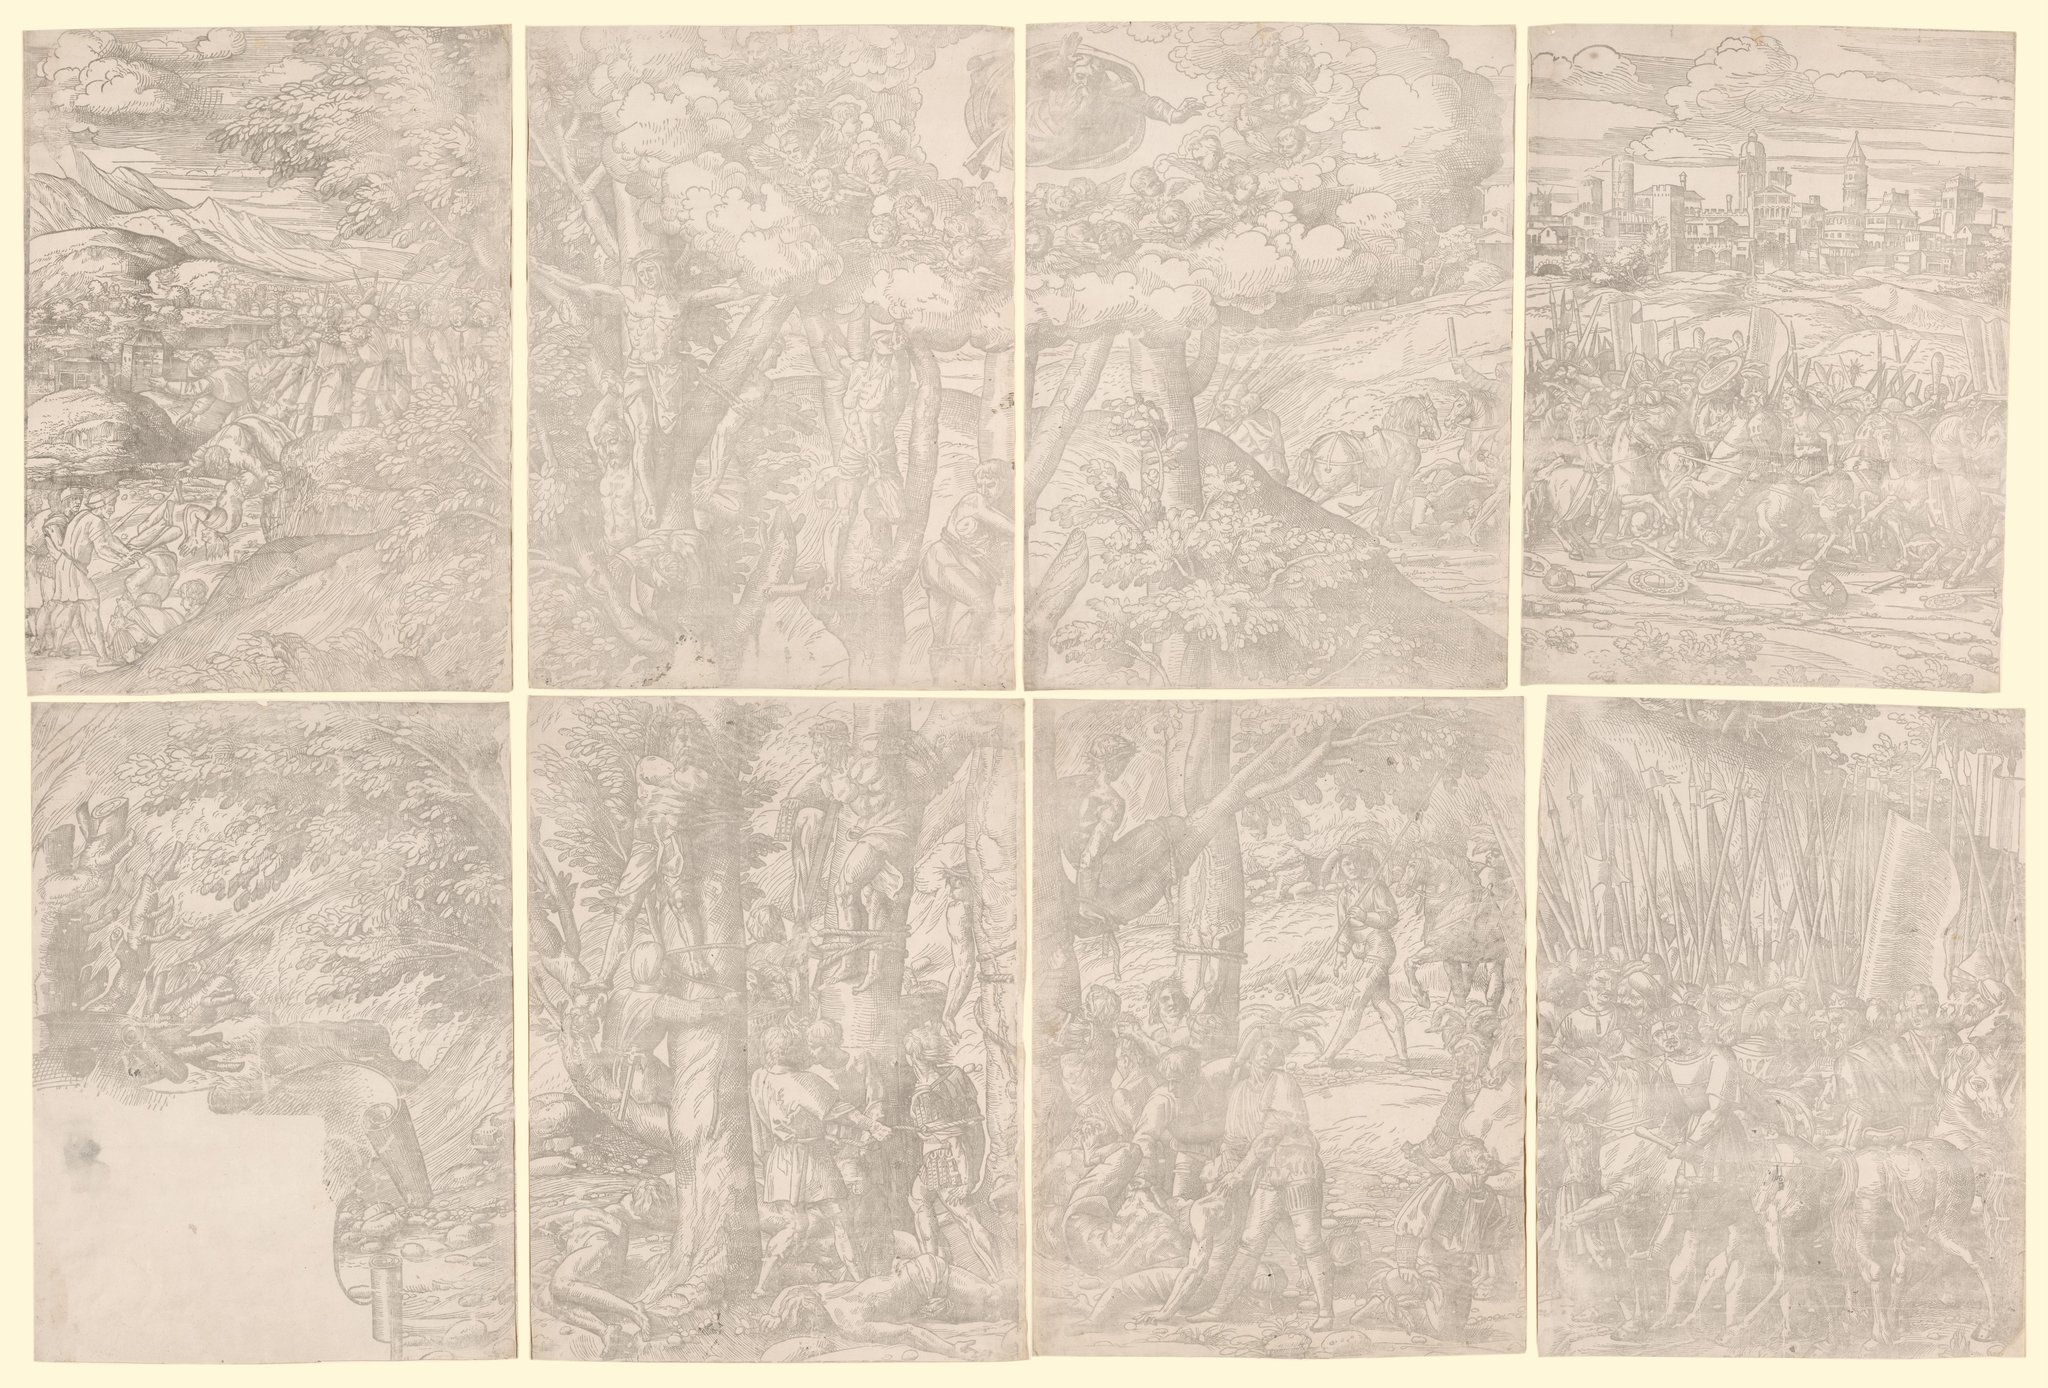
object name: print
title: Martelaarschap van de tienduizend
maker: domenico campagnola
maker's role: draughtsman, painter, print maker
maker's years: 1500-1564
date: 1515-1520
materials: paper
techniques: printmaking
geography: italy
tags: city-view in general; 'veduta', god the father, the martyrdom of achatius and his 10.000 companions on mount ararat: they are crucified and/or impaled on trees or thorns, ornament ~ cartouche, cupids: 'amores', 'amoretti', 'putti'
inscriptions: collector's mark: Lugt 240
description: De Romeinse legerleider Achatius van Ararat en zijn 10.000 volgelingen zijn ter dood gebracht omdat zij zich hadden bekeerd tot het christendom. In het midden worden zij aan bomen gehangen, en rechts worden zij van de rotsen gegooid. Midden boven God de Vader omringd door putti.